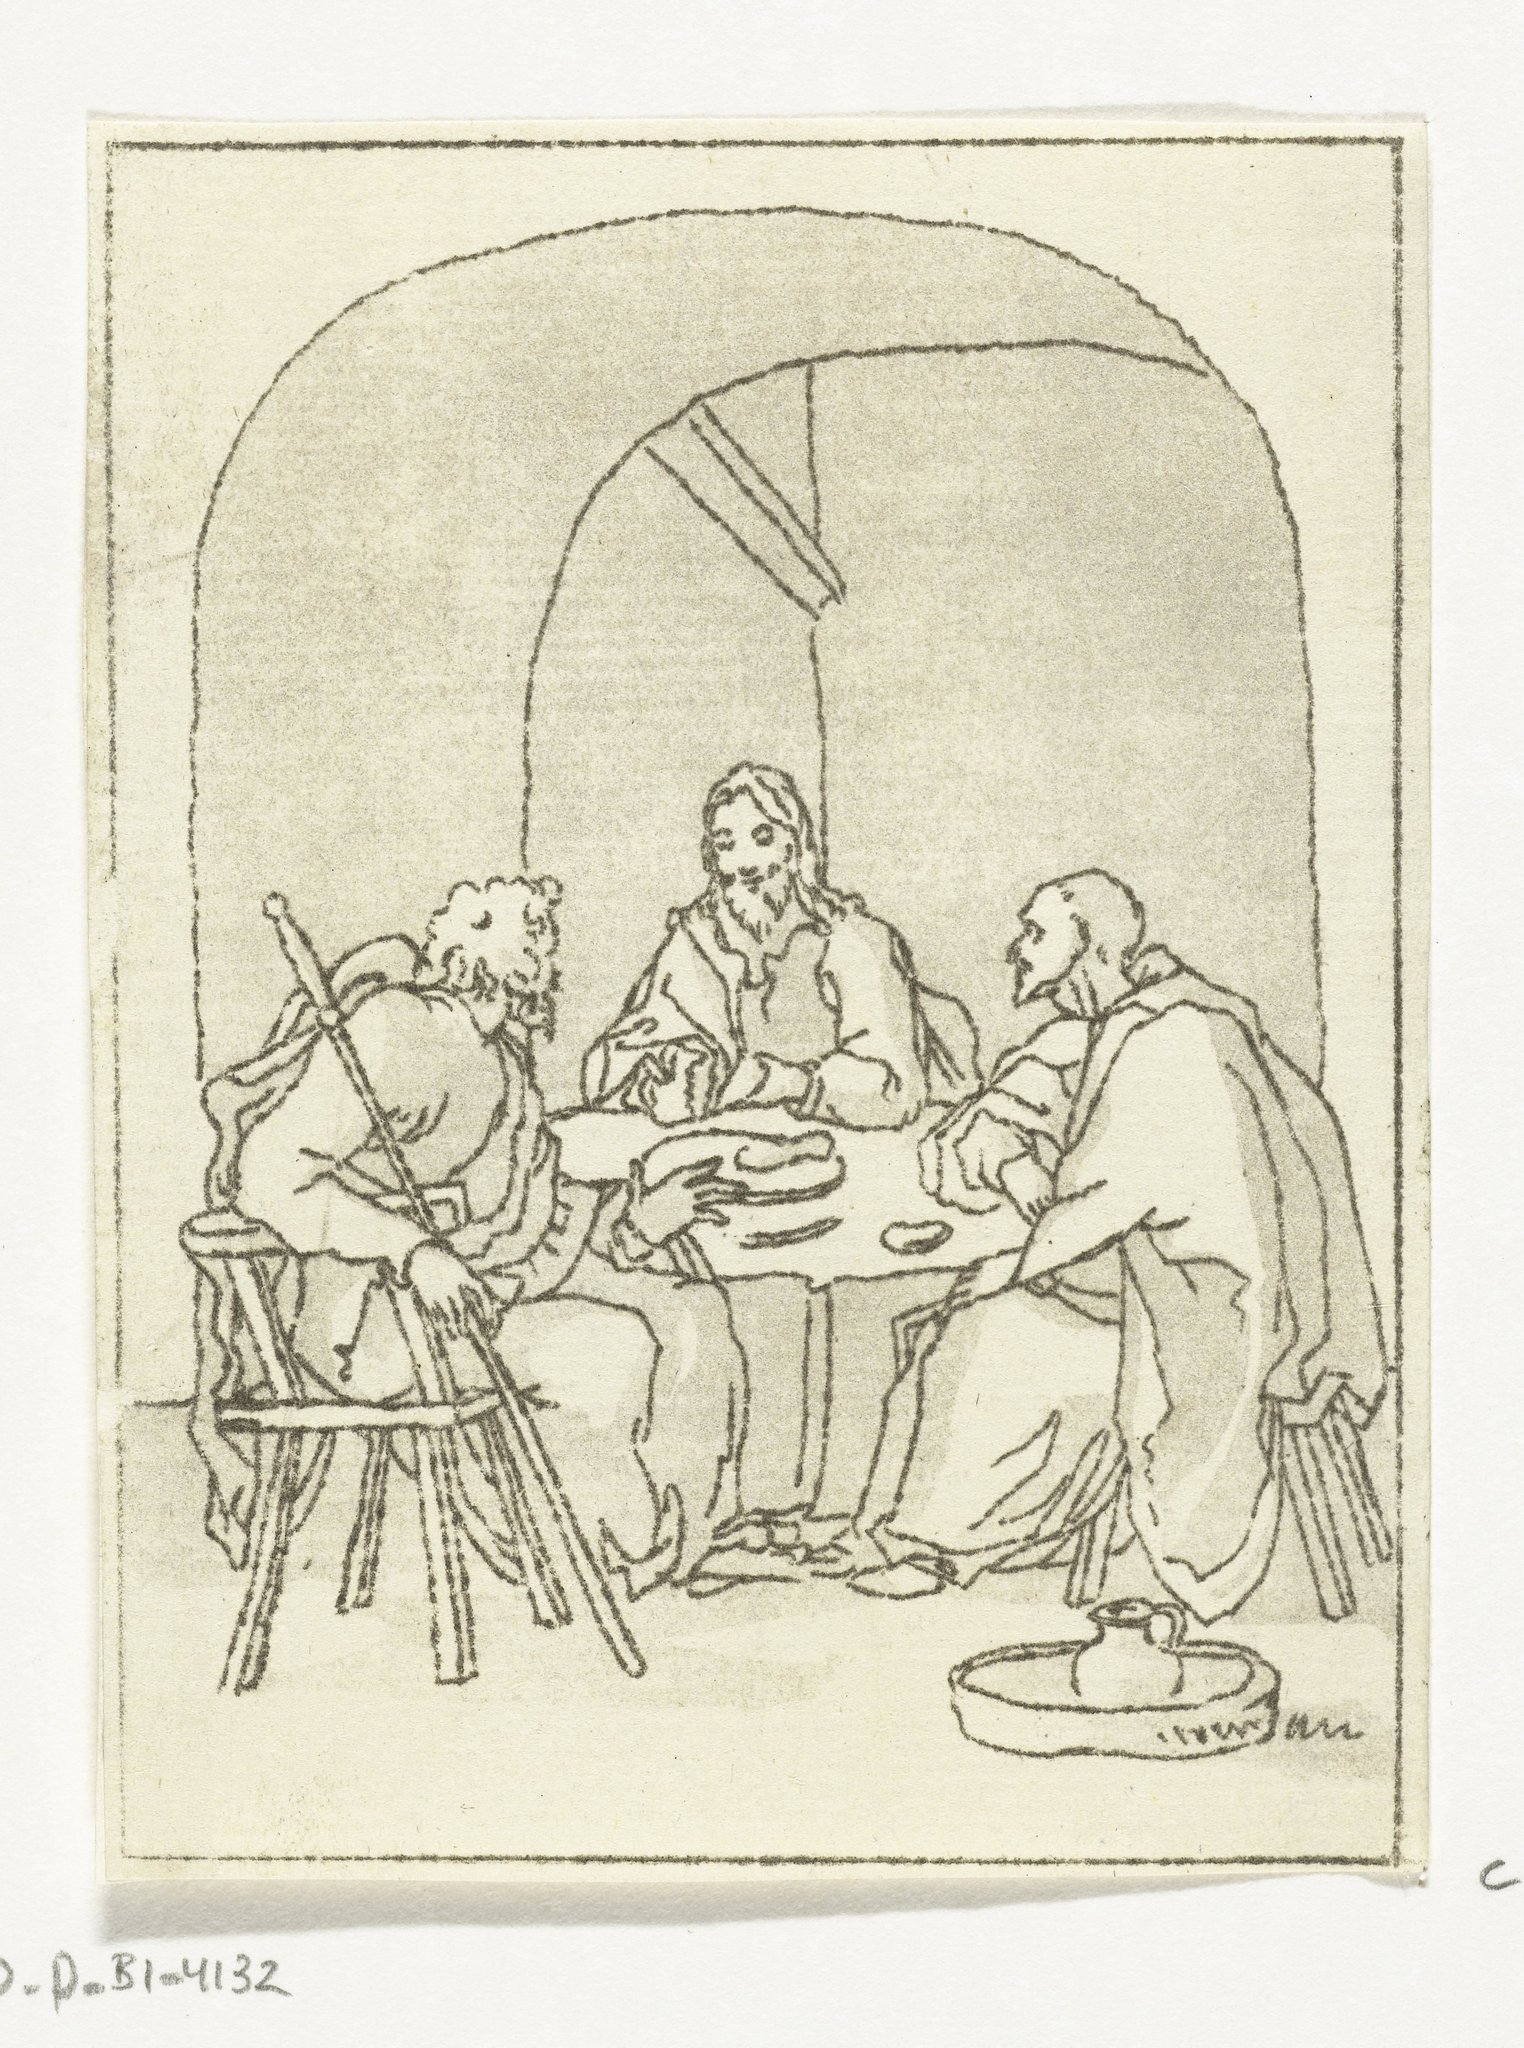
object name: print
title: Maaltijd te Emmaüs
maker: anthonie van den bos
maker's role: draughtsman, print maker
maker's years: 1763-1838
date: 1778-1838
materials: paper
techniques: printmaking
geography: netherlands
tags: simon the cyrenian compelled to help christ to bear the cross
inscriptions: collector's mark: Lugt 2228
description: Christus zit met de Emmaüsgangers aan tafel. Hij breekt het brood en spreekt de zegen uit en op dat moment herkennen de twee mannen hem.